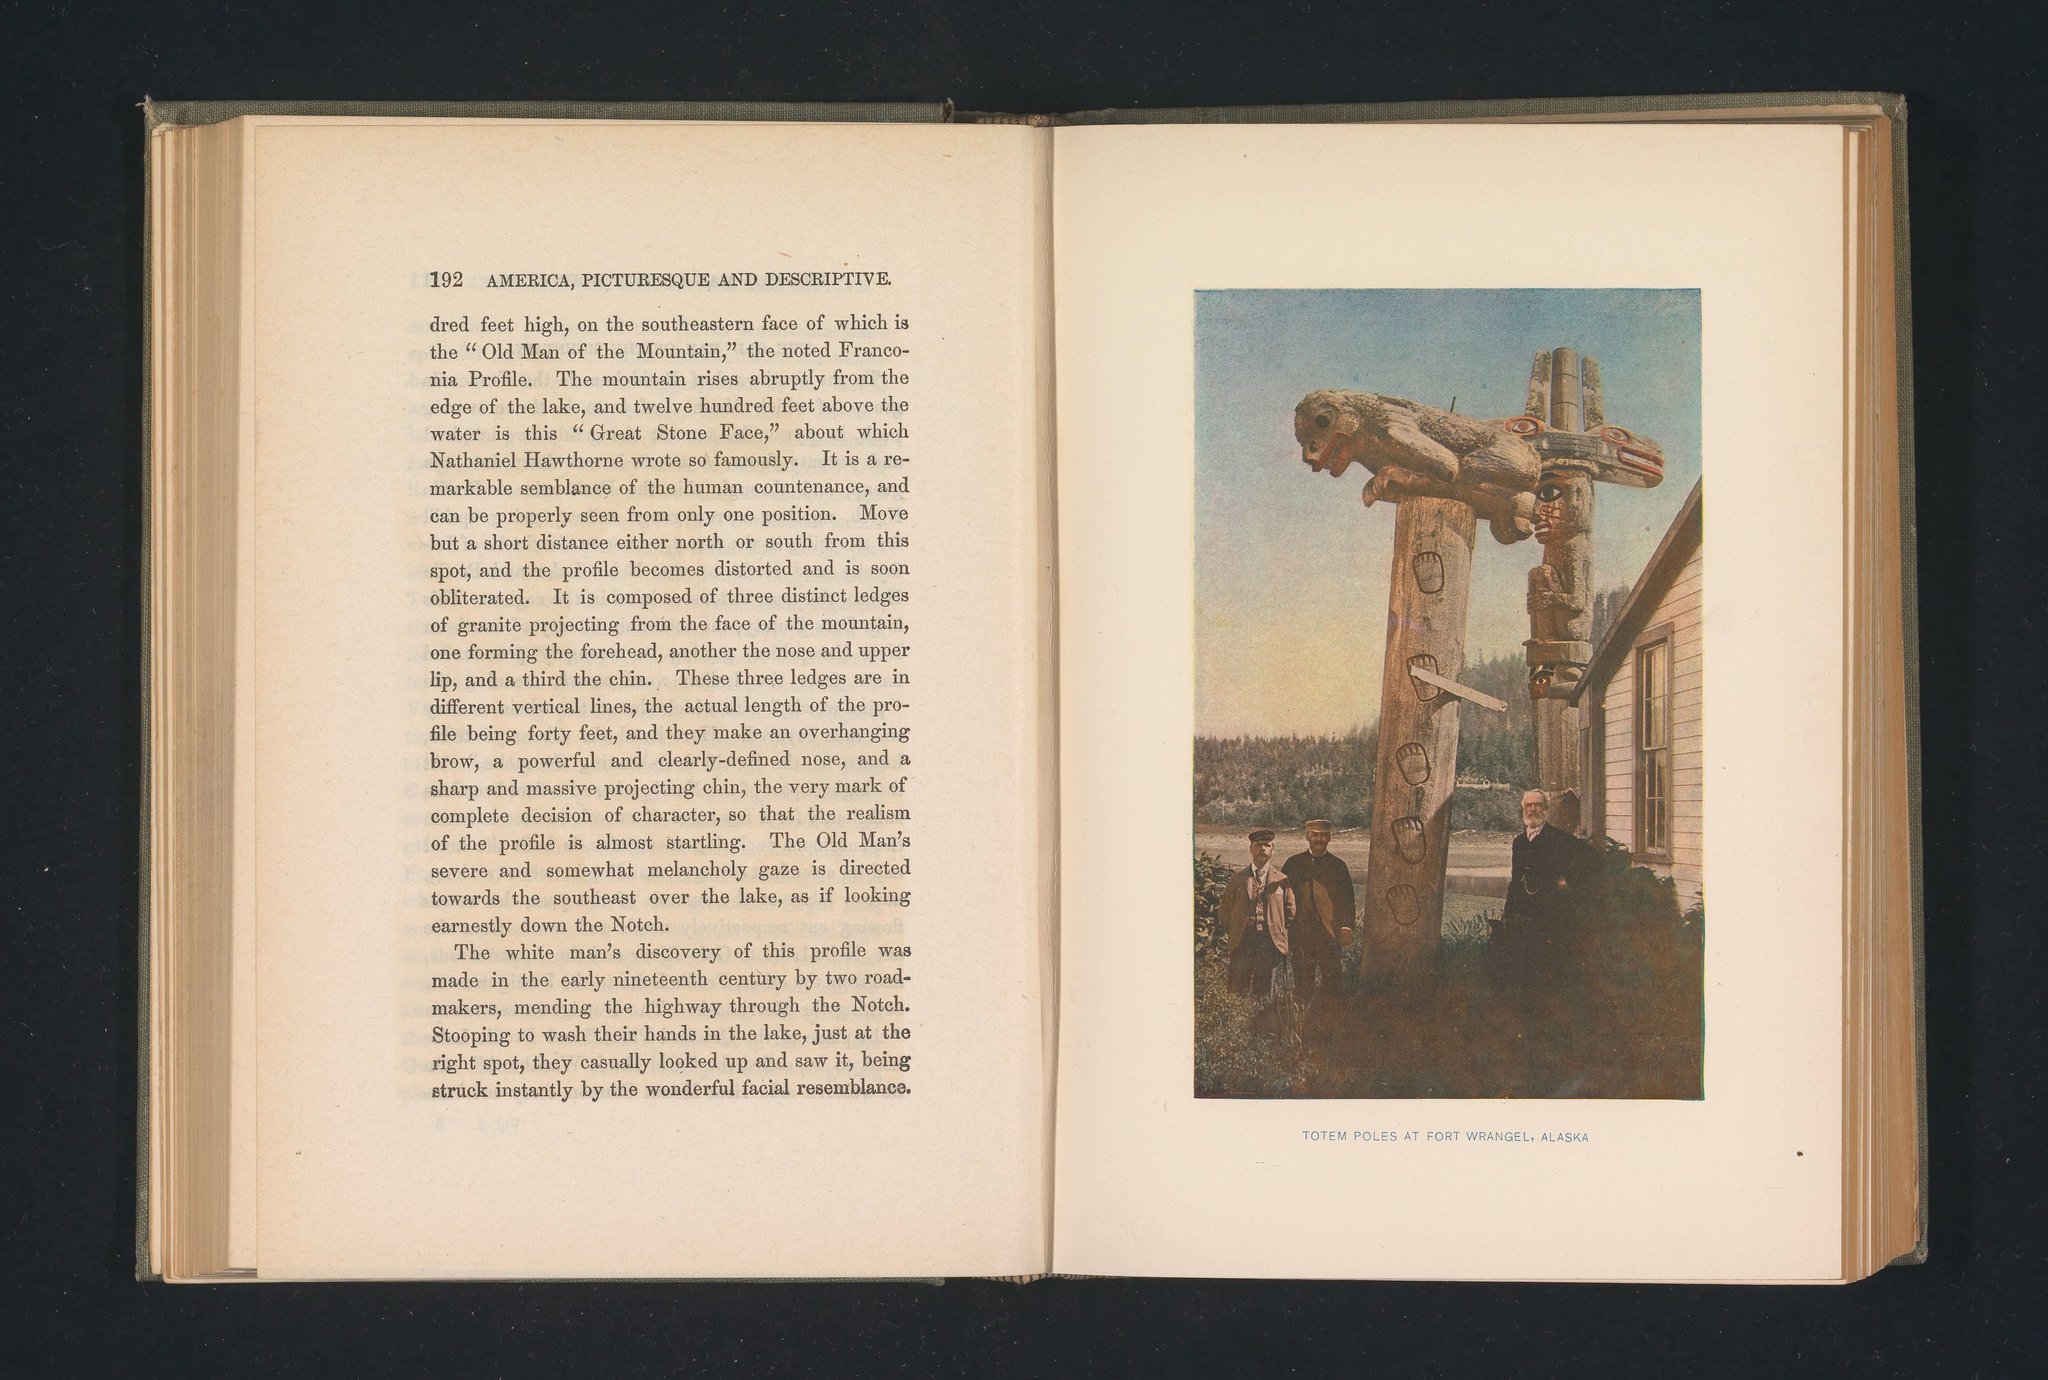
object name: photomechanical print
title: Totem poles at Fort Wrangel, Alaska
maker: Anonymous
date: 1890-1900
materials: paper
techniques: color autotype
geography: wrangell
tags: column, pillar ~ architecture, ritual objects and ritual means ~ american indian religions, façade (of house or building)